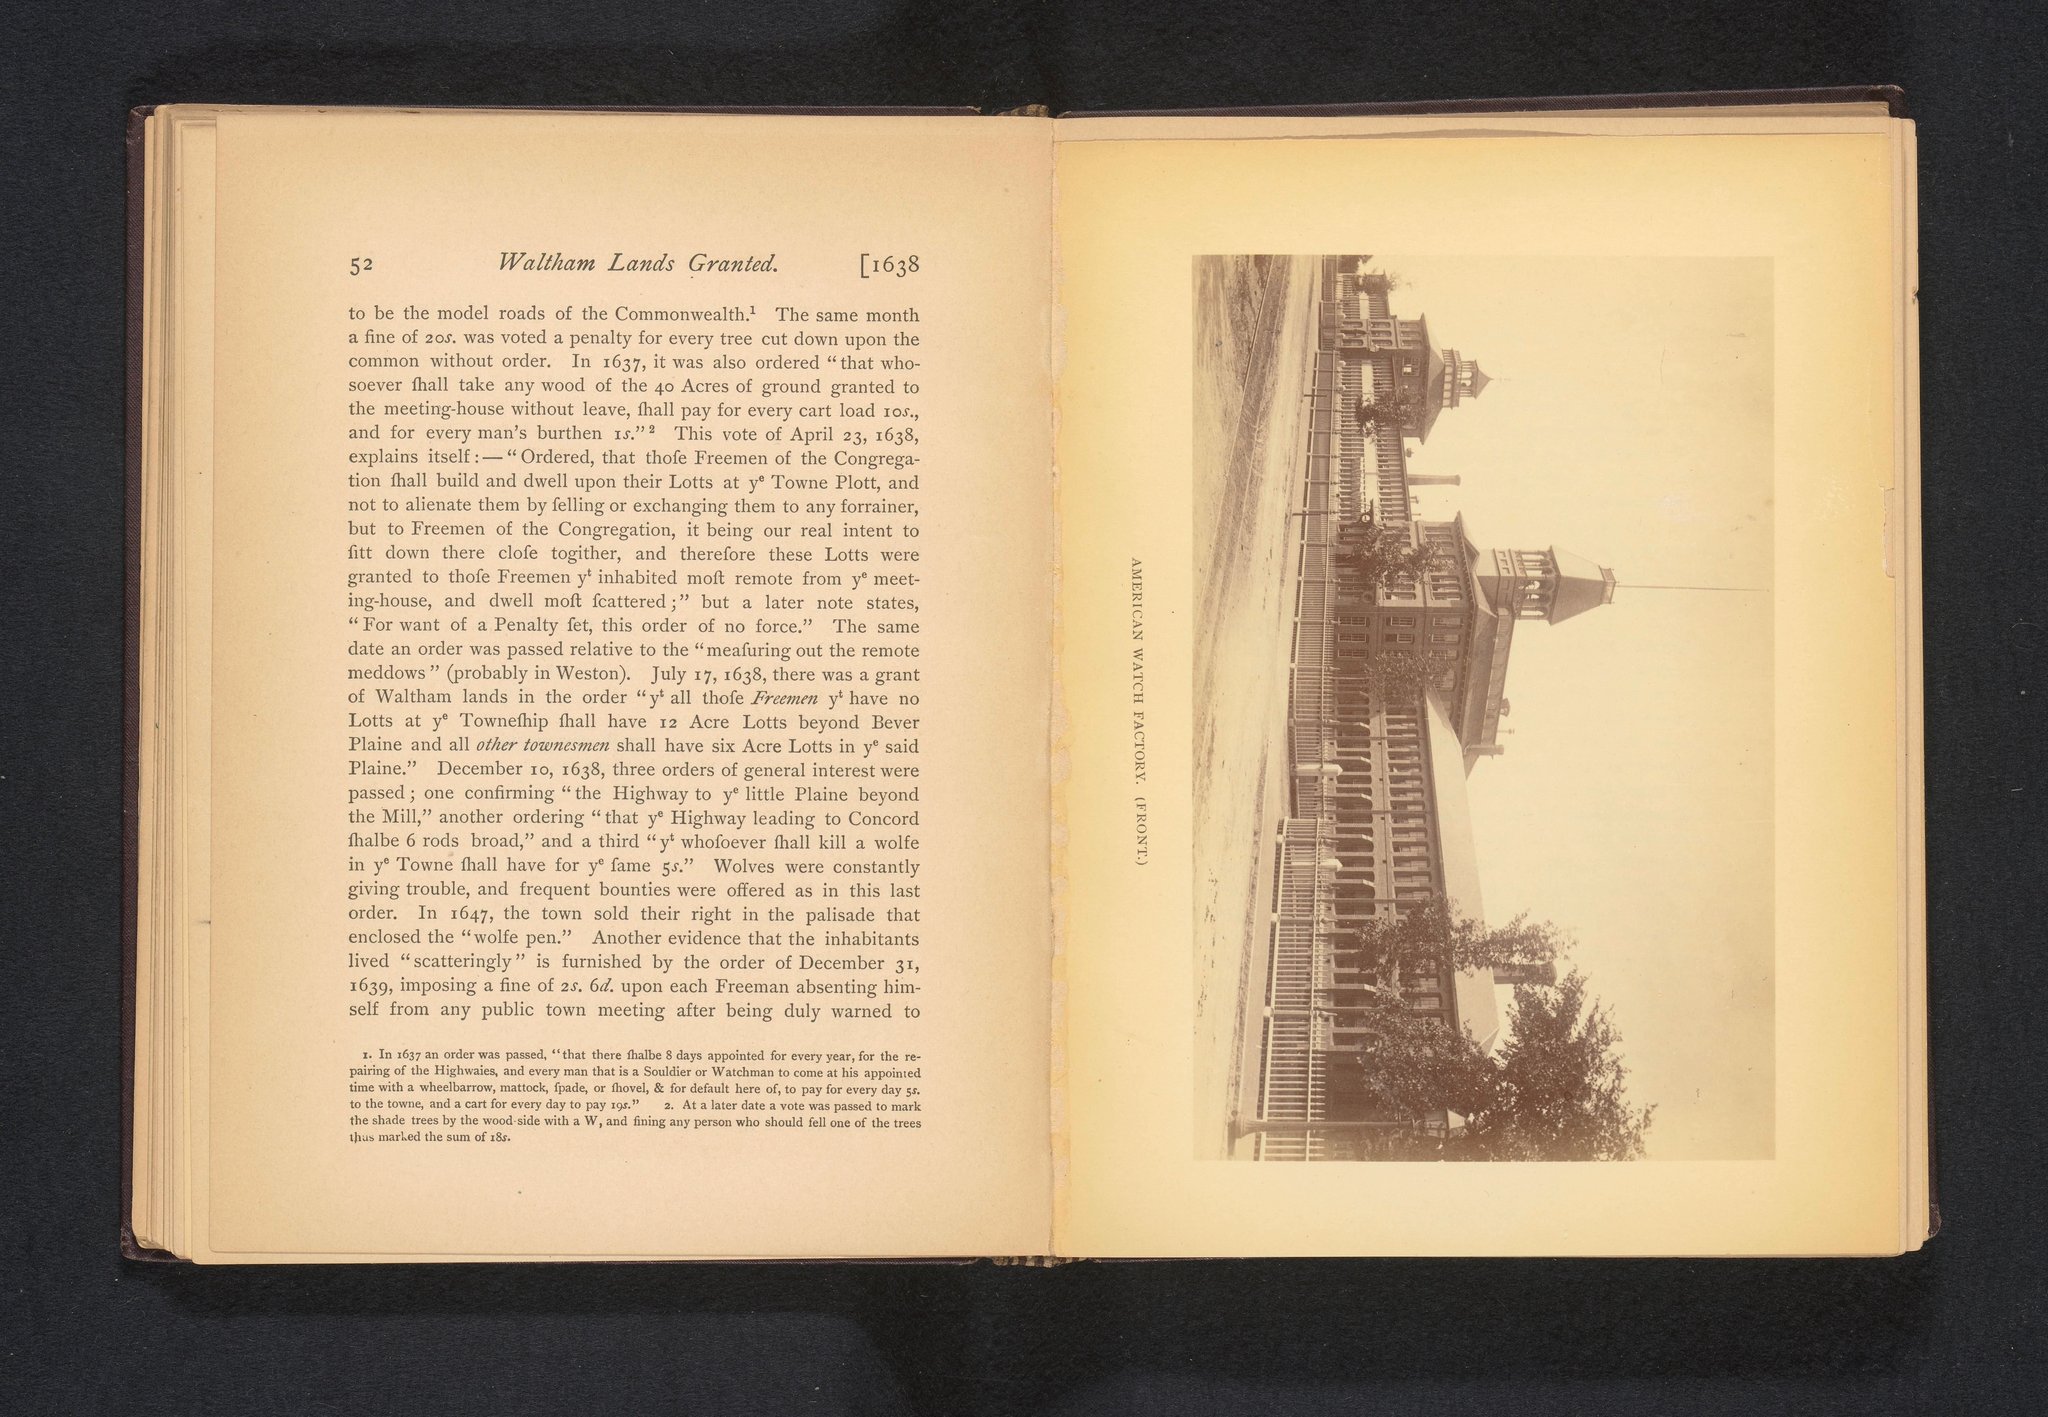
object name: photograph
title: American Watch Factory. (Front.)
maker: thomas r. lewis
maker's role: publisher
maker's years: 1845-1901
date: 1874-1879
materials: photographic support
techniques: albumen print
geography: waltham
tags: factory-building